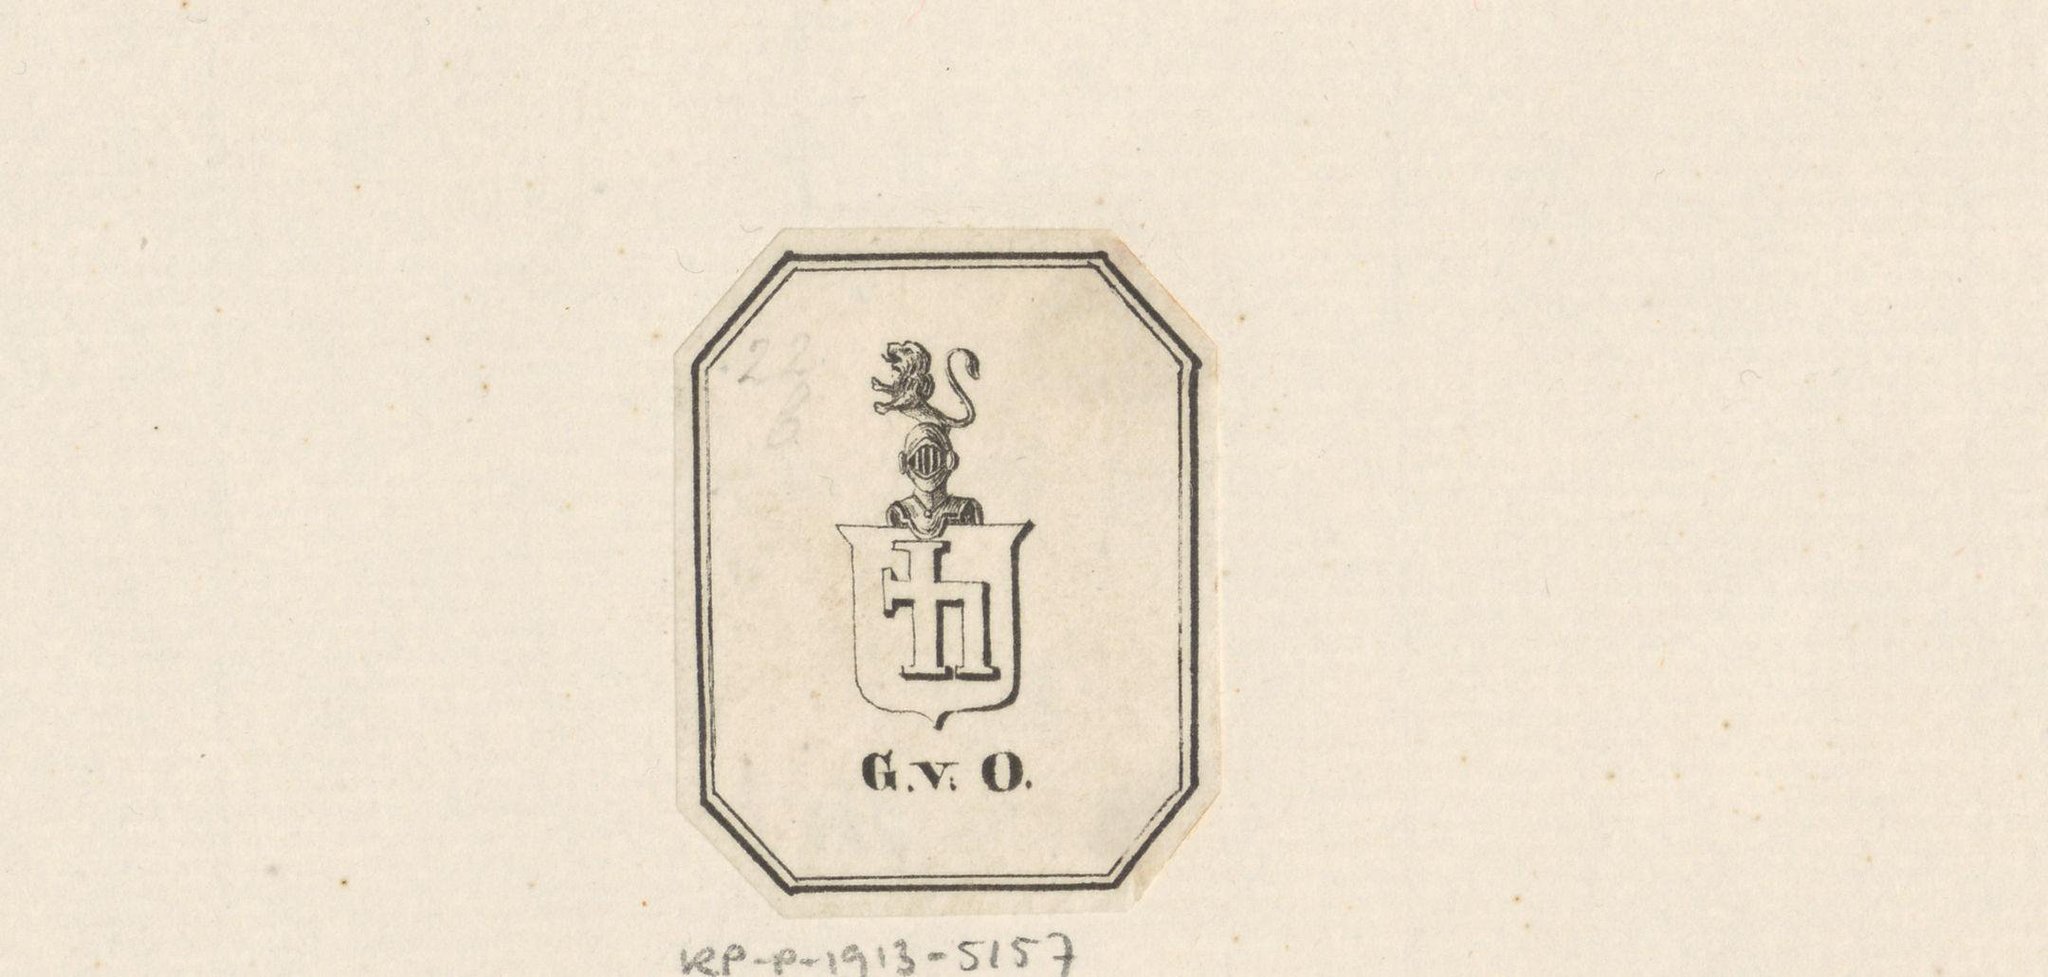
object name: bookplate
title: Ex libris van G.v.O.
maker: Anonymous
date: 1784-1854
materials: paper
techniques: etching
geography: netherlands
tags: mayor, gerrit van orden, beasts of prey, predatory animals: lion, armorial bearing, heraldry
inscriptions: collector's mark: Lugt 2760, collector's mark: Lugt 2233